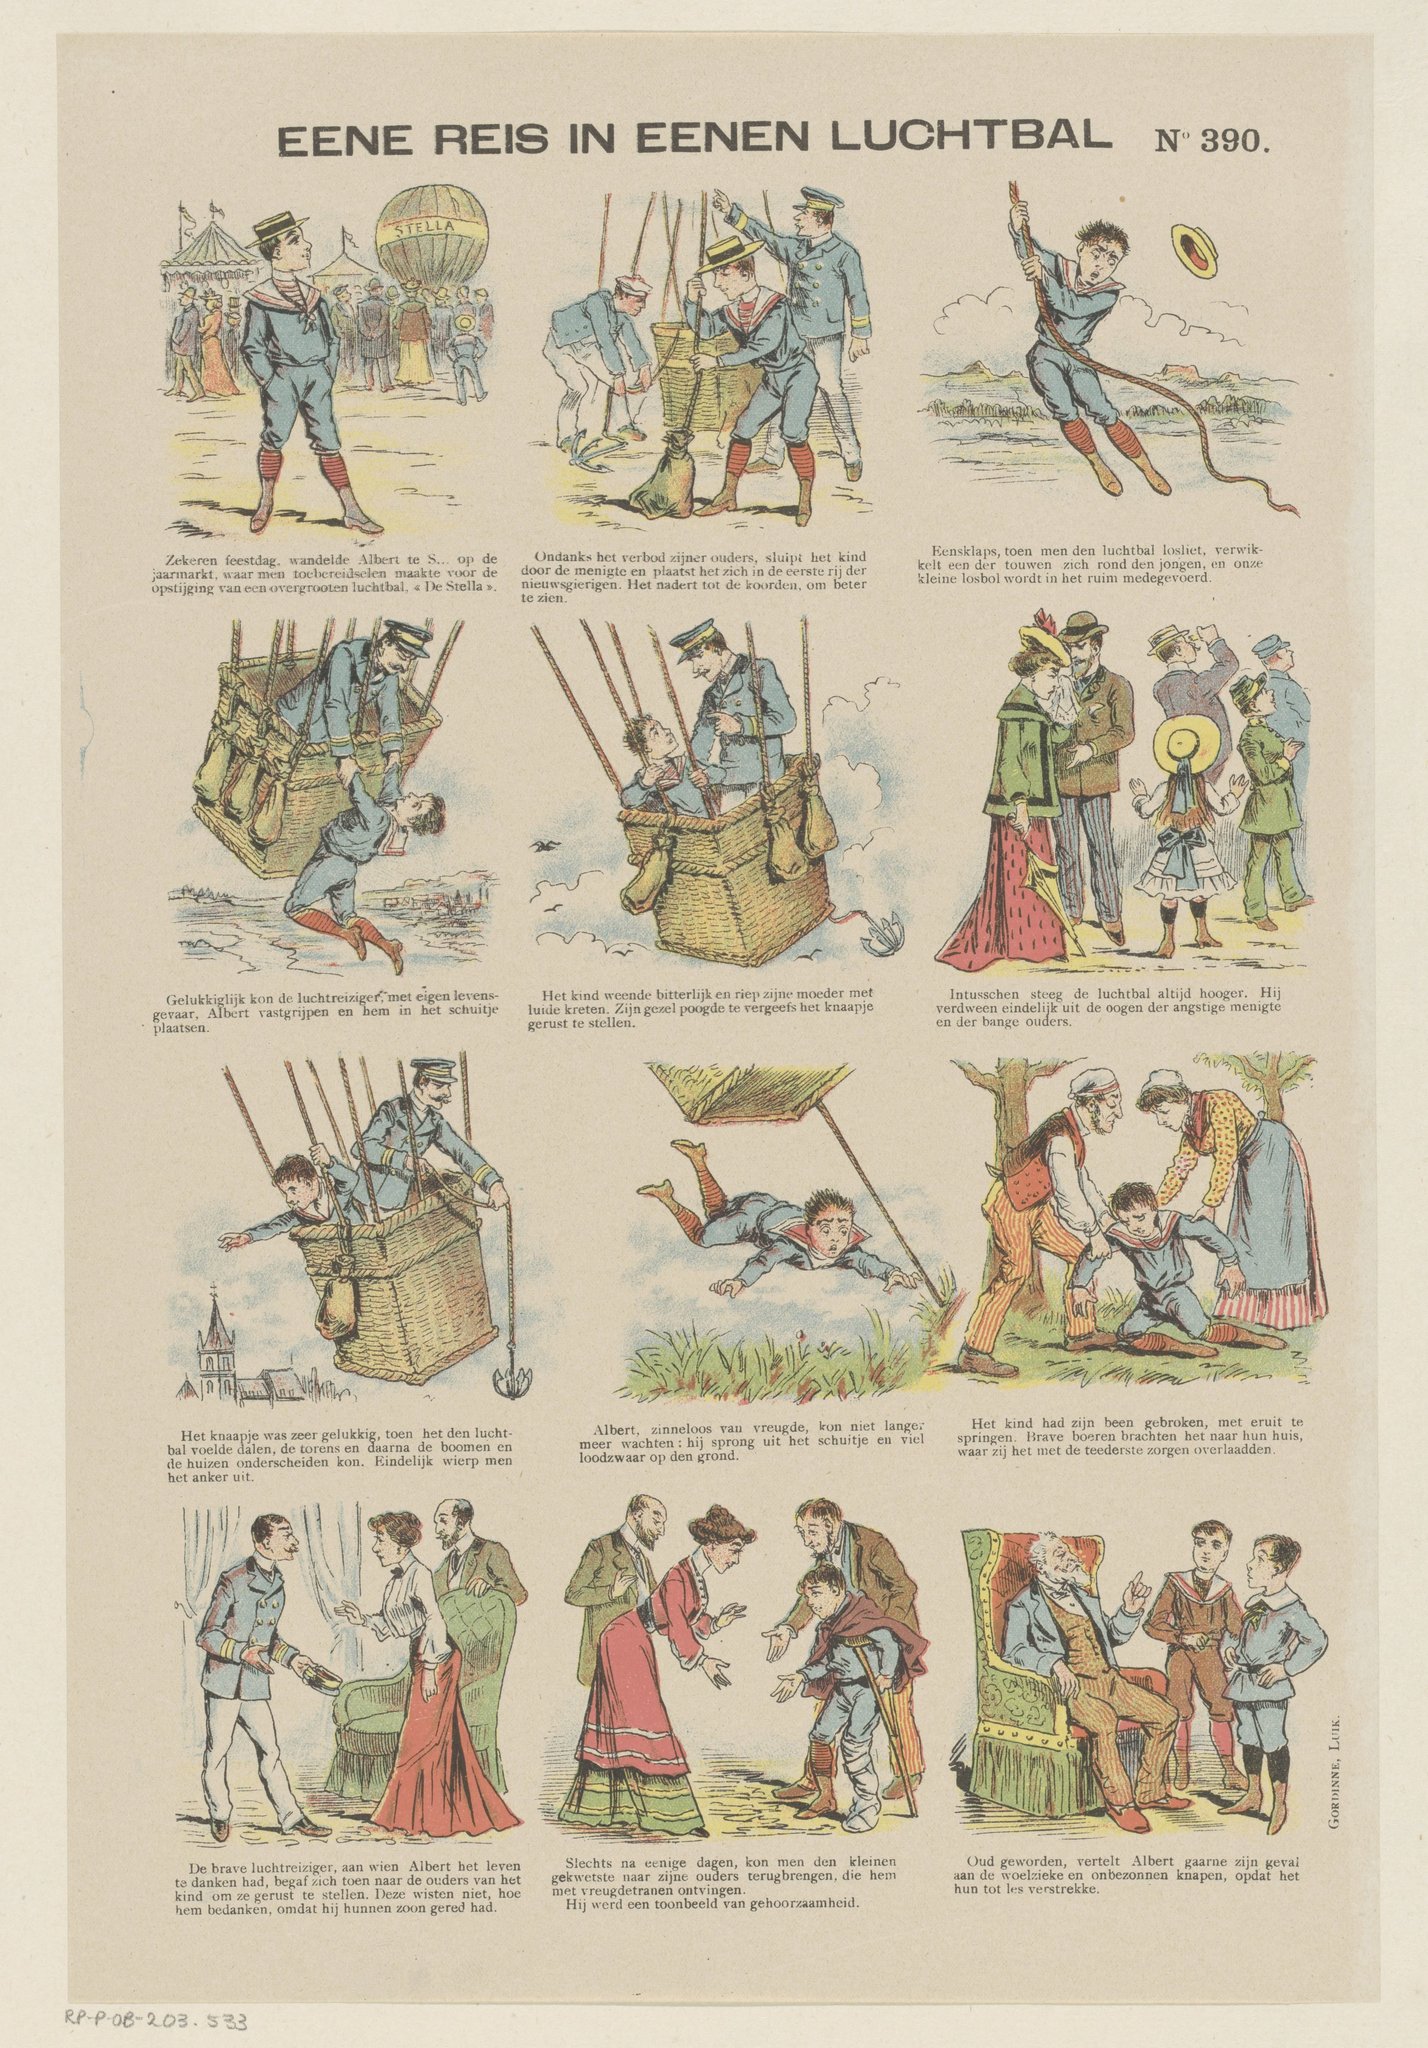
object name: popular print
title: Eene reis in eenen luchtbal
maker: Anonymous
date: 1894-1959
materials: paper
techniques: lithograph, letterpress printing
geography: liège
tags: balloon flight (sport)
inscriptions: collector's mark: Lugt 2760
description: Blad met 12 voorstellingen over de nieuwsgierige jongen Albert die per ongeluk een luchtballonvaart maakt. Onder elke afbeelding een onderschrift. Genummerd rechtsboven: No 390.